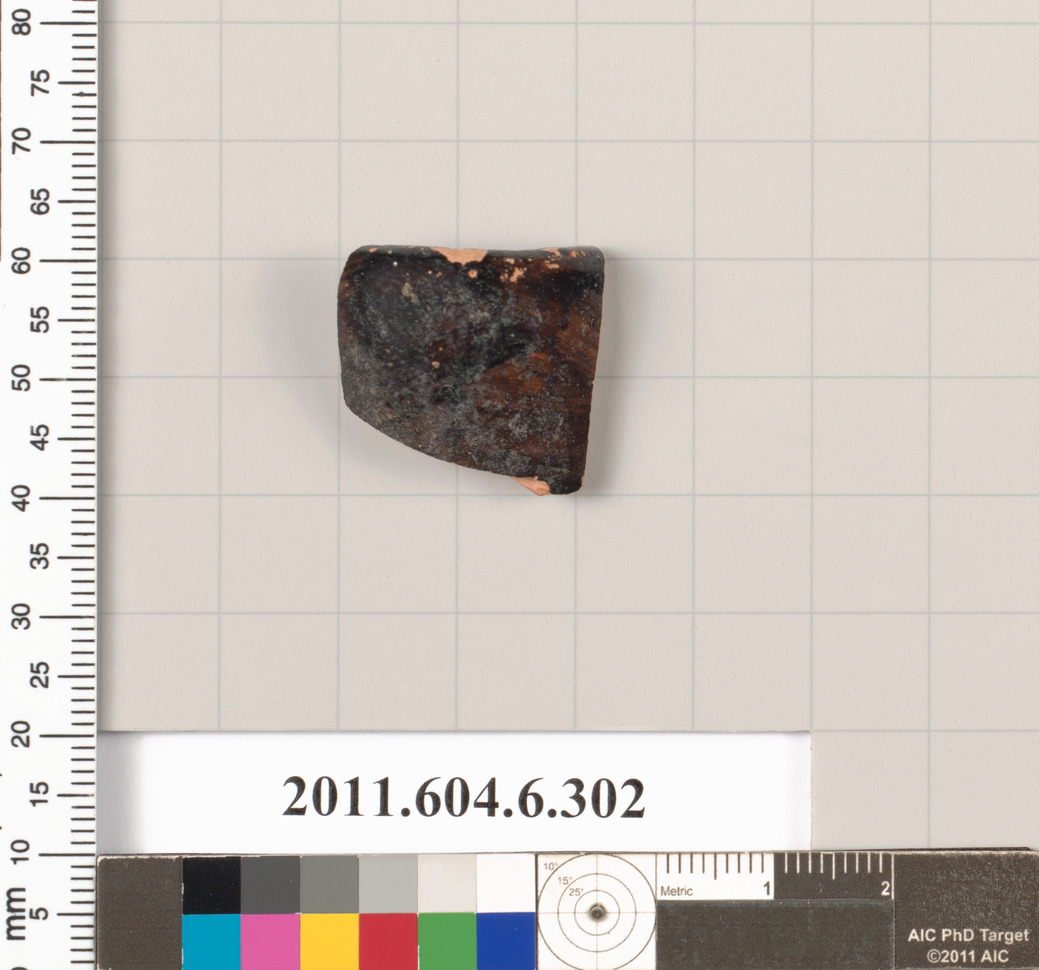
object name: oinochoe fragment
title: Terracotta fragment of an oinochoe (jug)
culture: greek, attic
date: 600-401 BCE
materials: terracotta